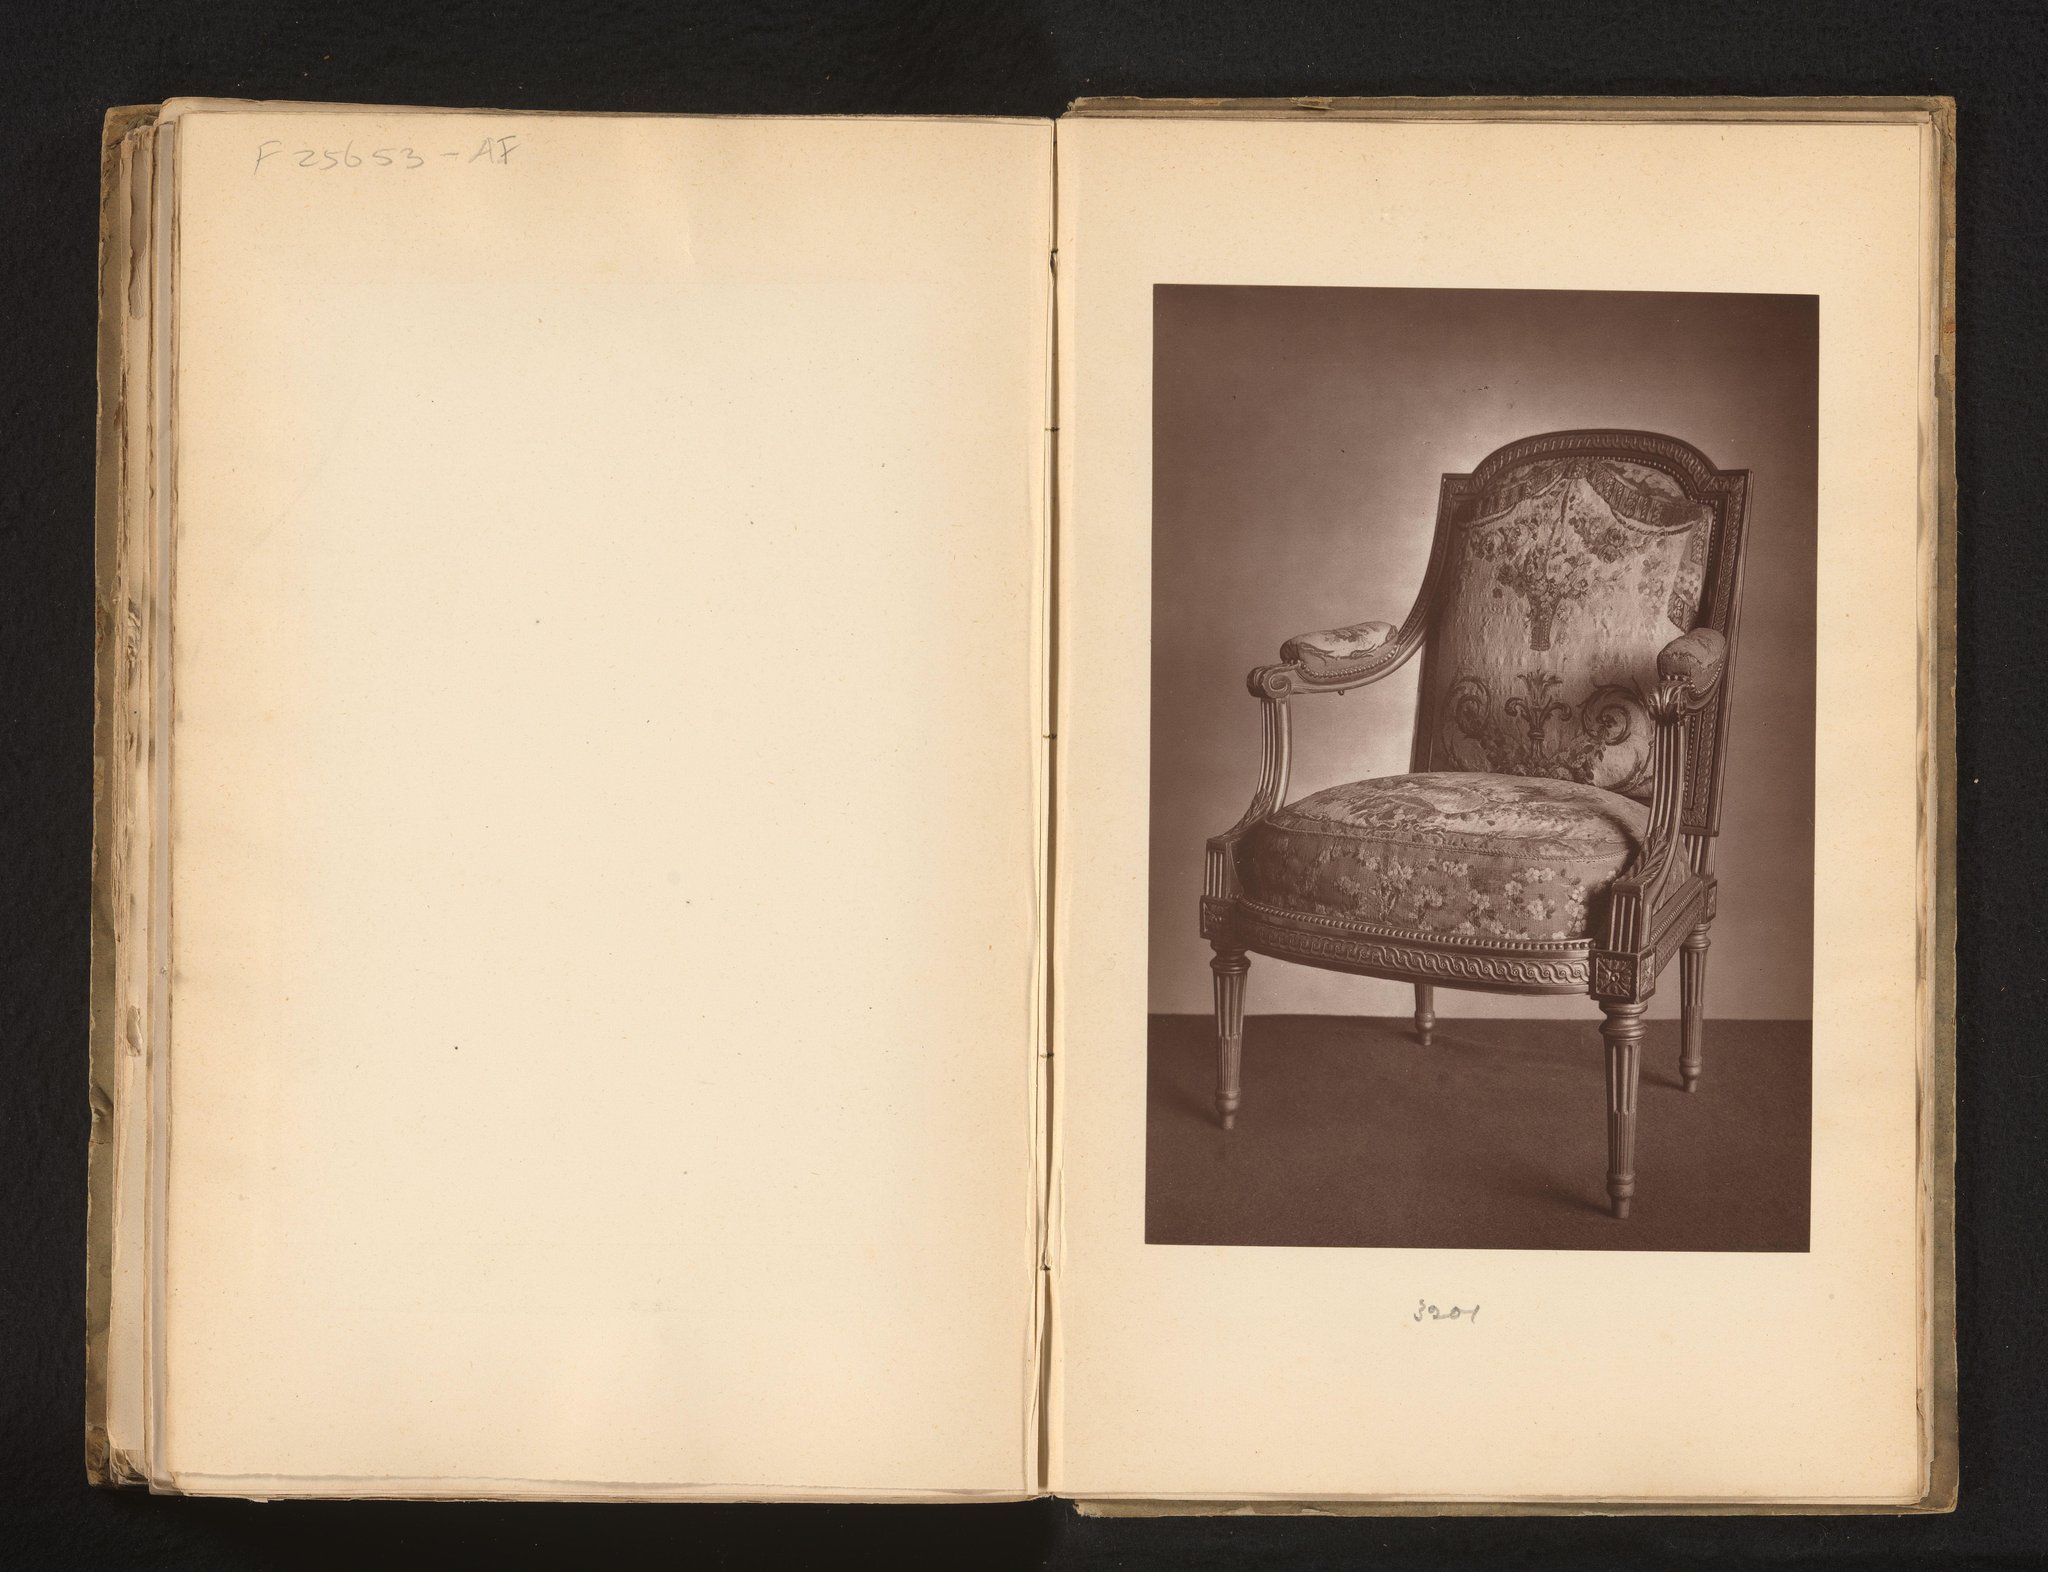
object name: page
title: Vergulde zetel in de stijl van Lodewijk XVI, uit de collectie van Christopher Beckett Denison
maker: Anonymous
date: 1880-1885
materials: paper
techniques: woodburytype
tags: armchair, seat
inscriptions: number: ‘3201’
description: Prent op derde ongenummerde pagina na pagina 270.